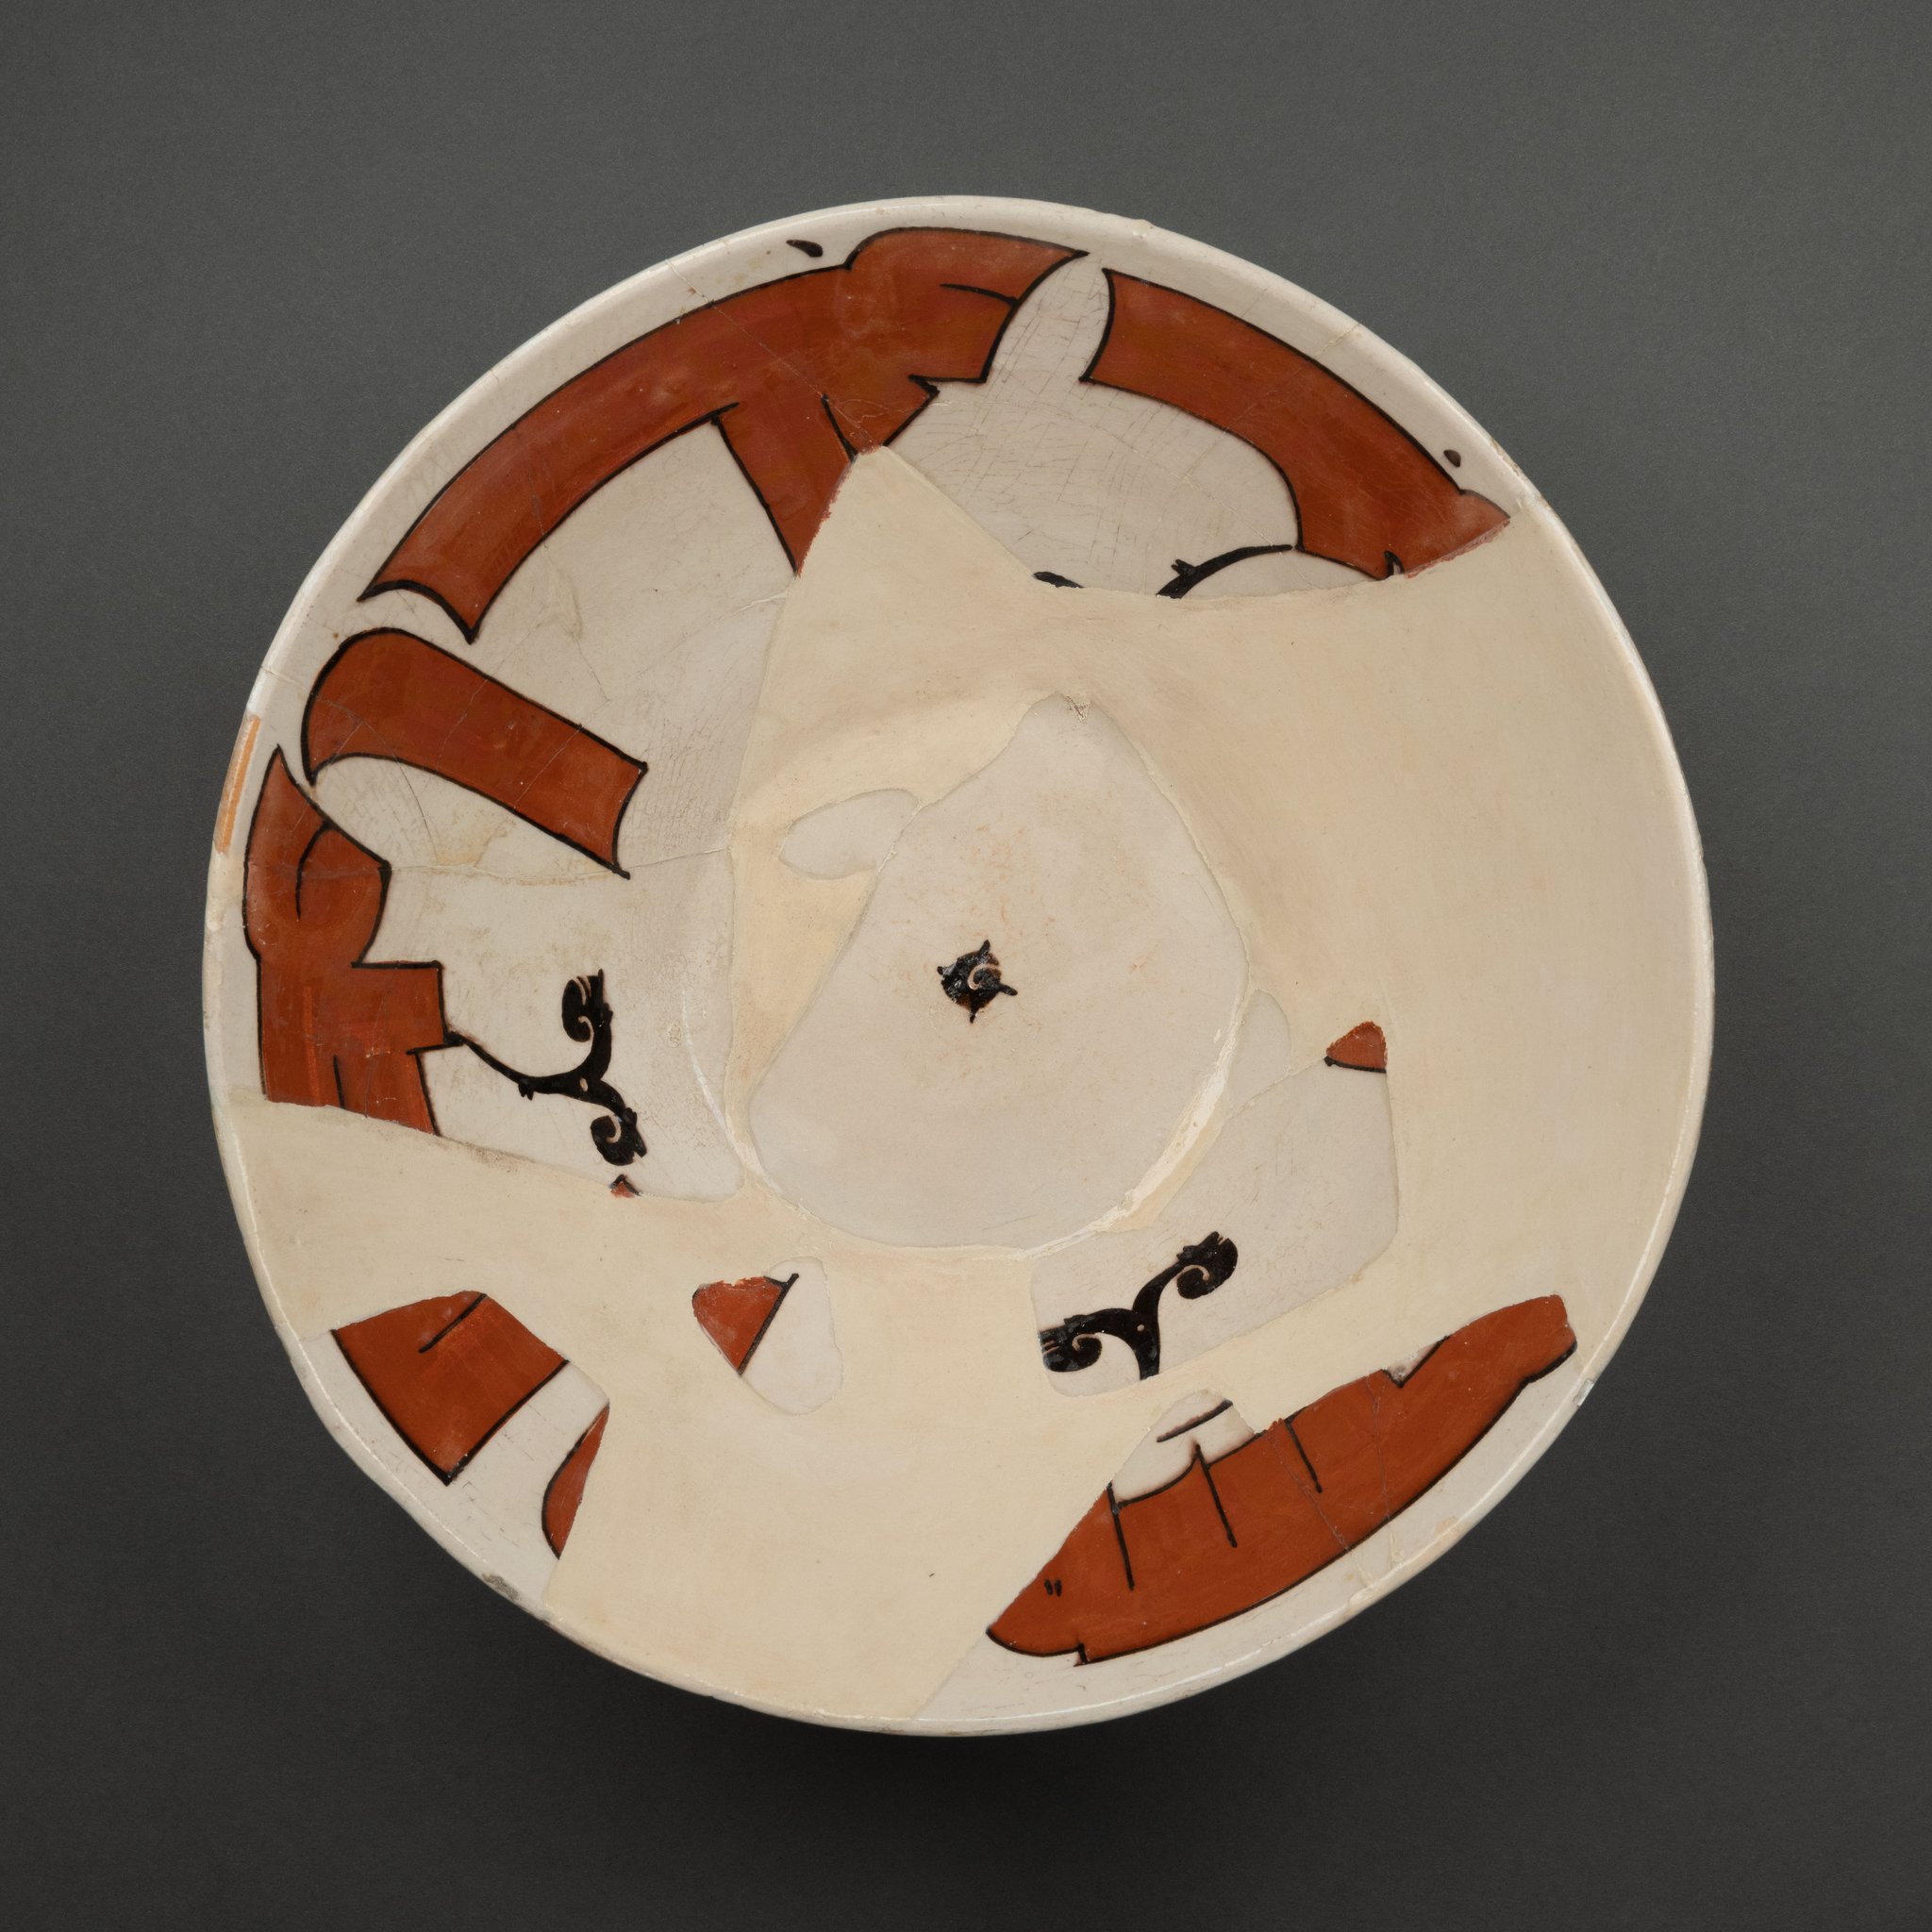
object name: bowl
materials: earthenware, glaze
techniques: polychrome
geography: iran